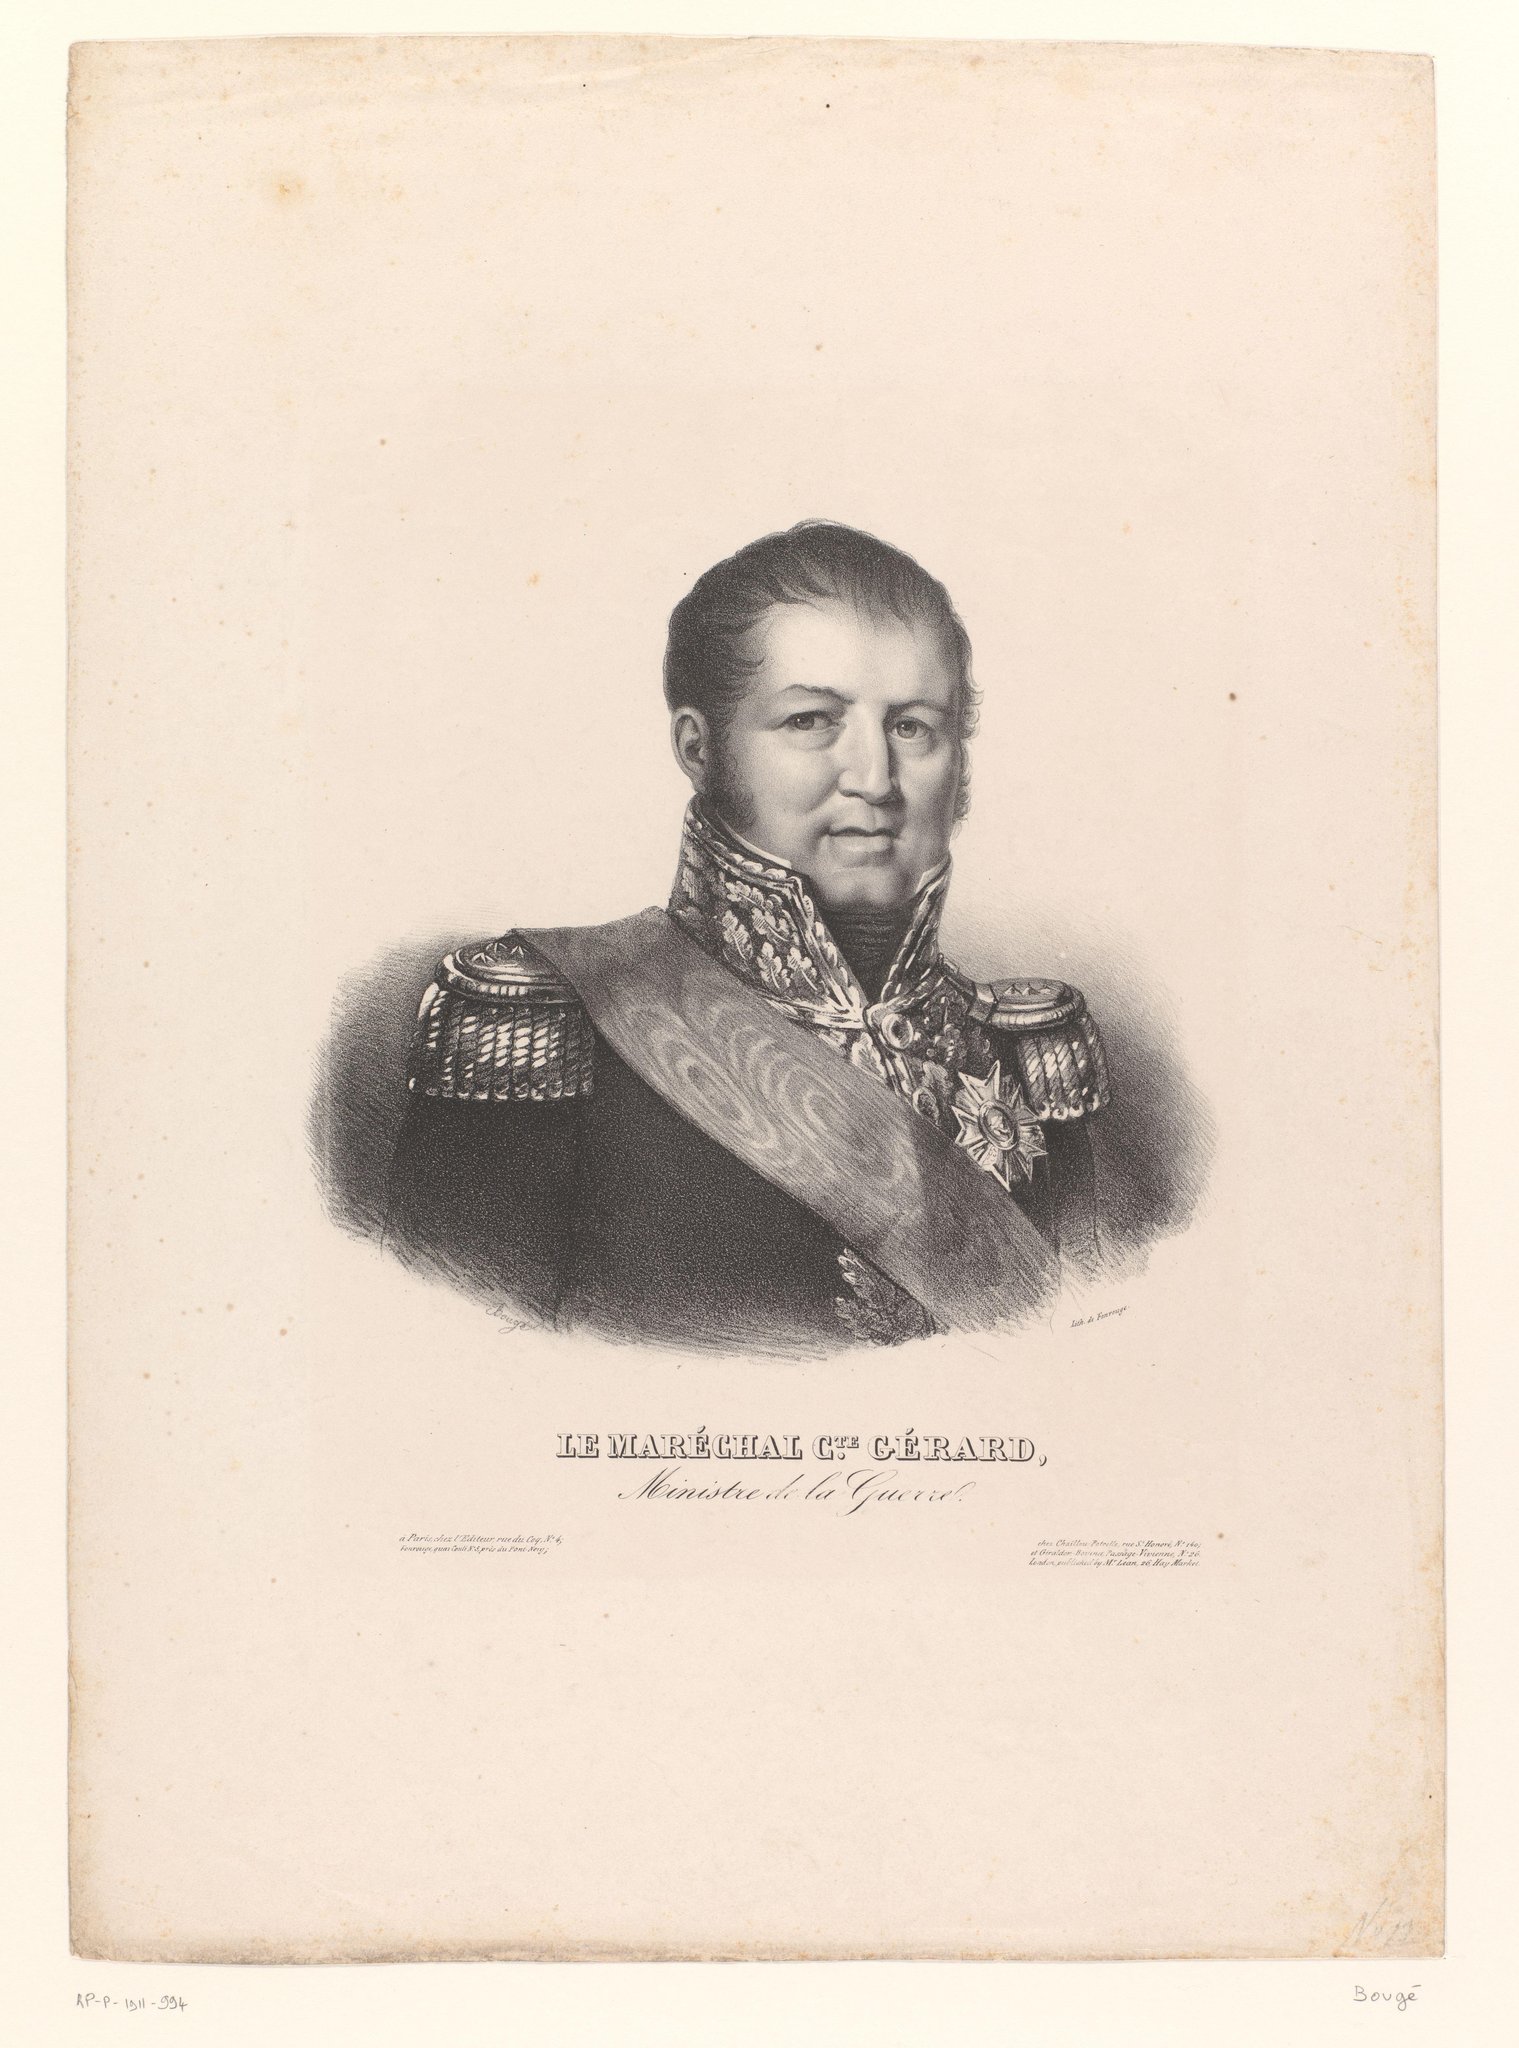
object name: print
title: Portret van maarschalk Étienne Maurice Gérard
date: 1831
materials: paper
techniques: lithograph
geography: paris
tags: historical persons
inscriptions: collector's mark: Lugt 2228a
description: Prent gepubliceerd in: 'Galerie Universelle de Blaisot', een boek met 38 portretten van eminente mannen en vrouwen van de zeventiende tot en met de negentiende eeuw.